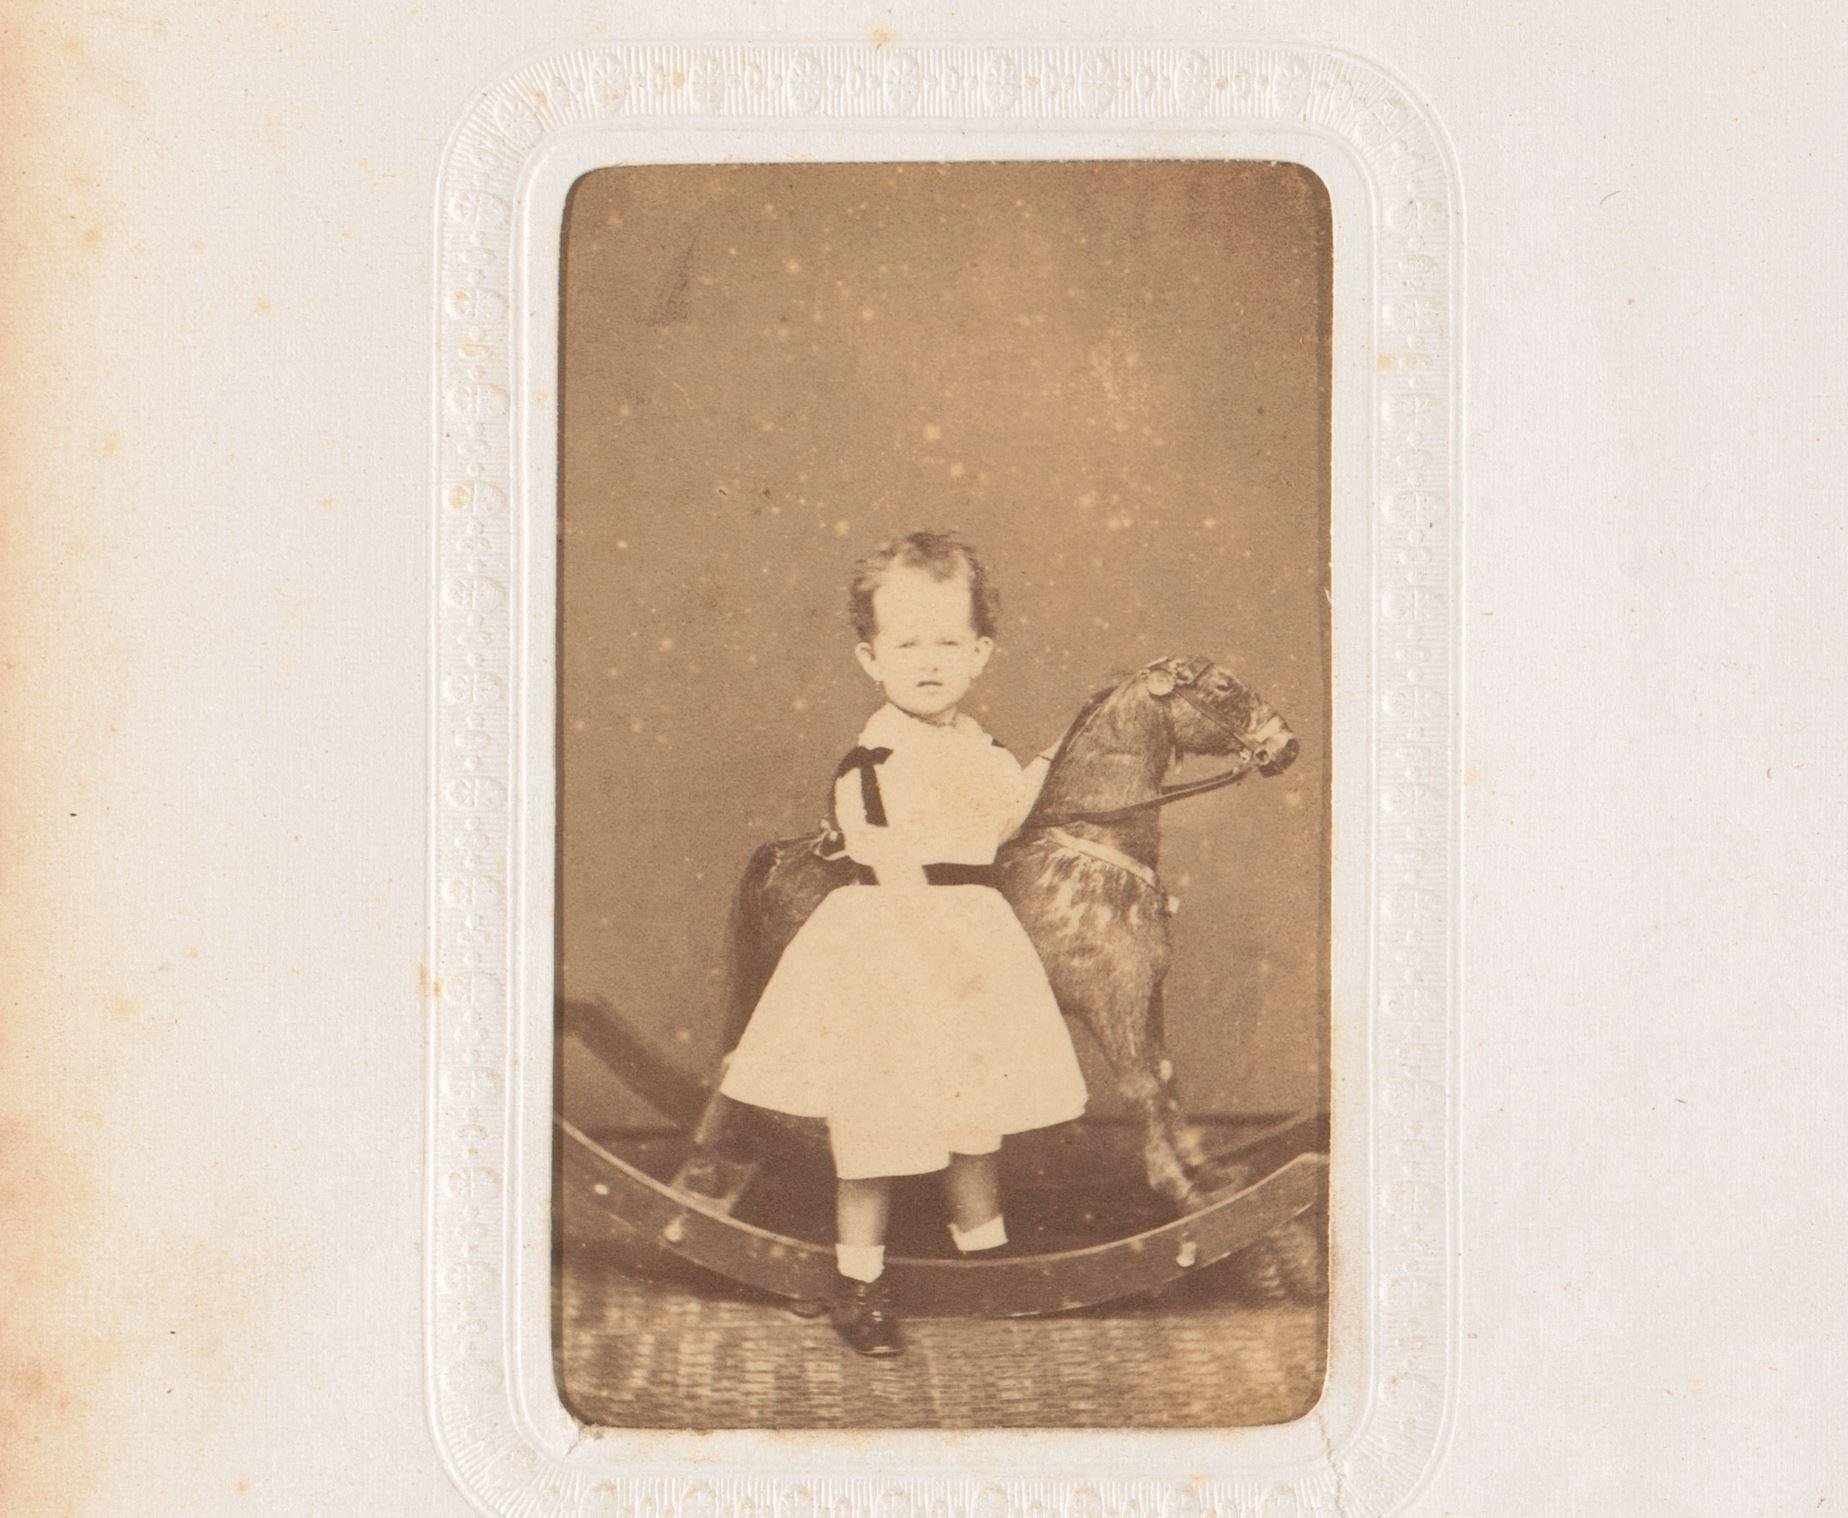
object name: photograph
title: Portret van een meisje in witte jurk, staand bij een hobbelpaard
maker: Anonymous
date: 1860-1900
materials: cardboard, photographic support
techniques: albumen print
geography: netherlands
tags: historical persons - bb - woman, toddler (female), rocking-horse